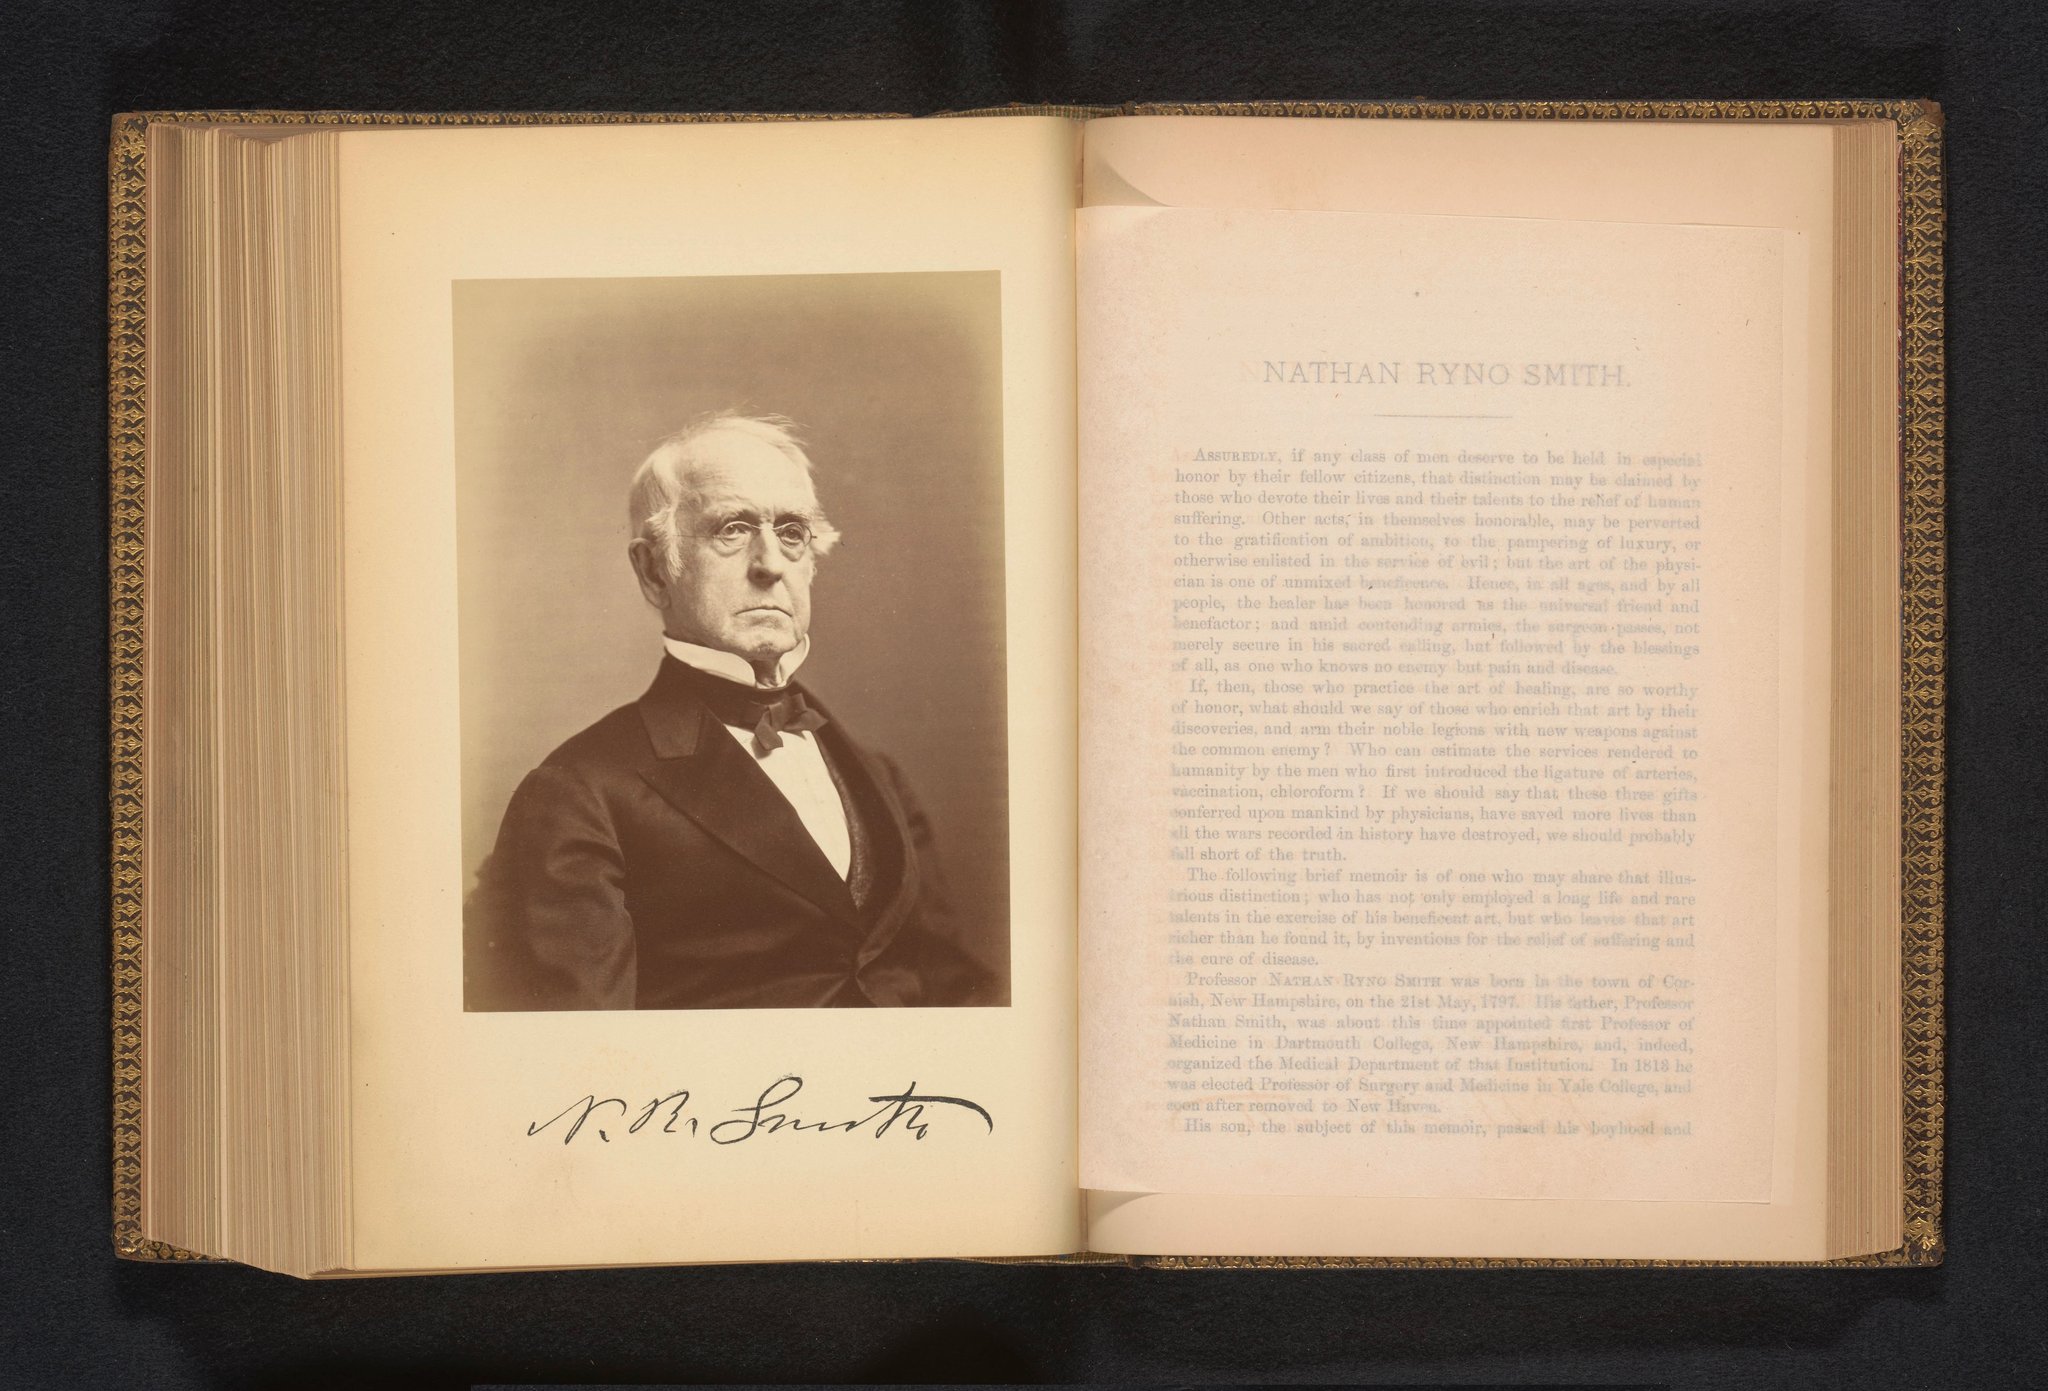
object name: page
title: N.R. Smith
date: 1866-1871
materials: photographic support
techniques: albumen print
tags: historical persons